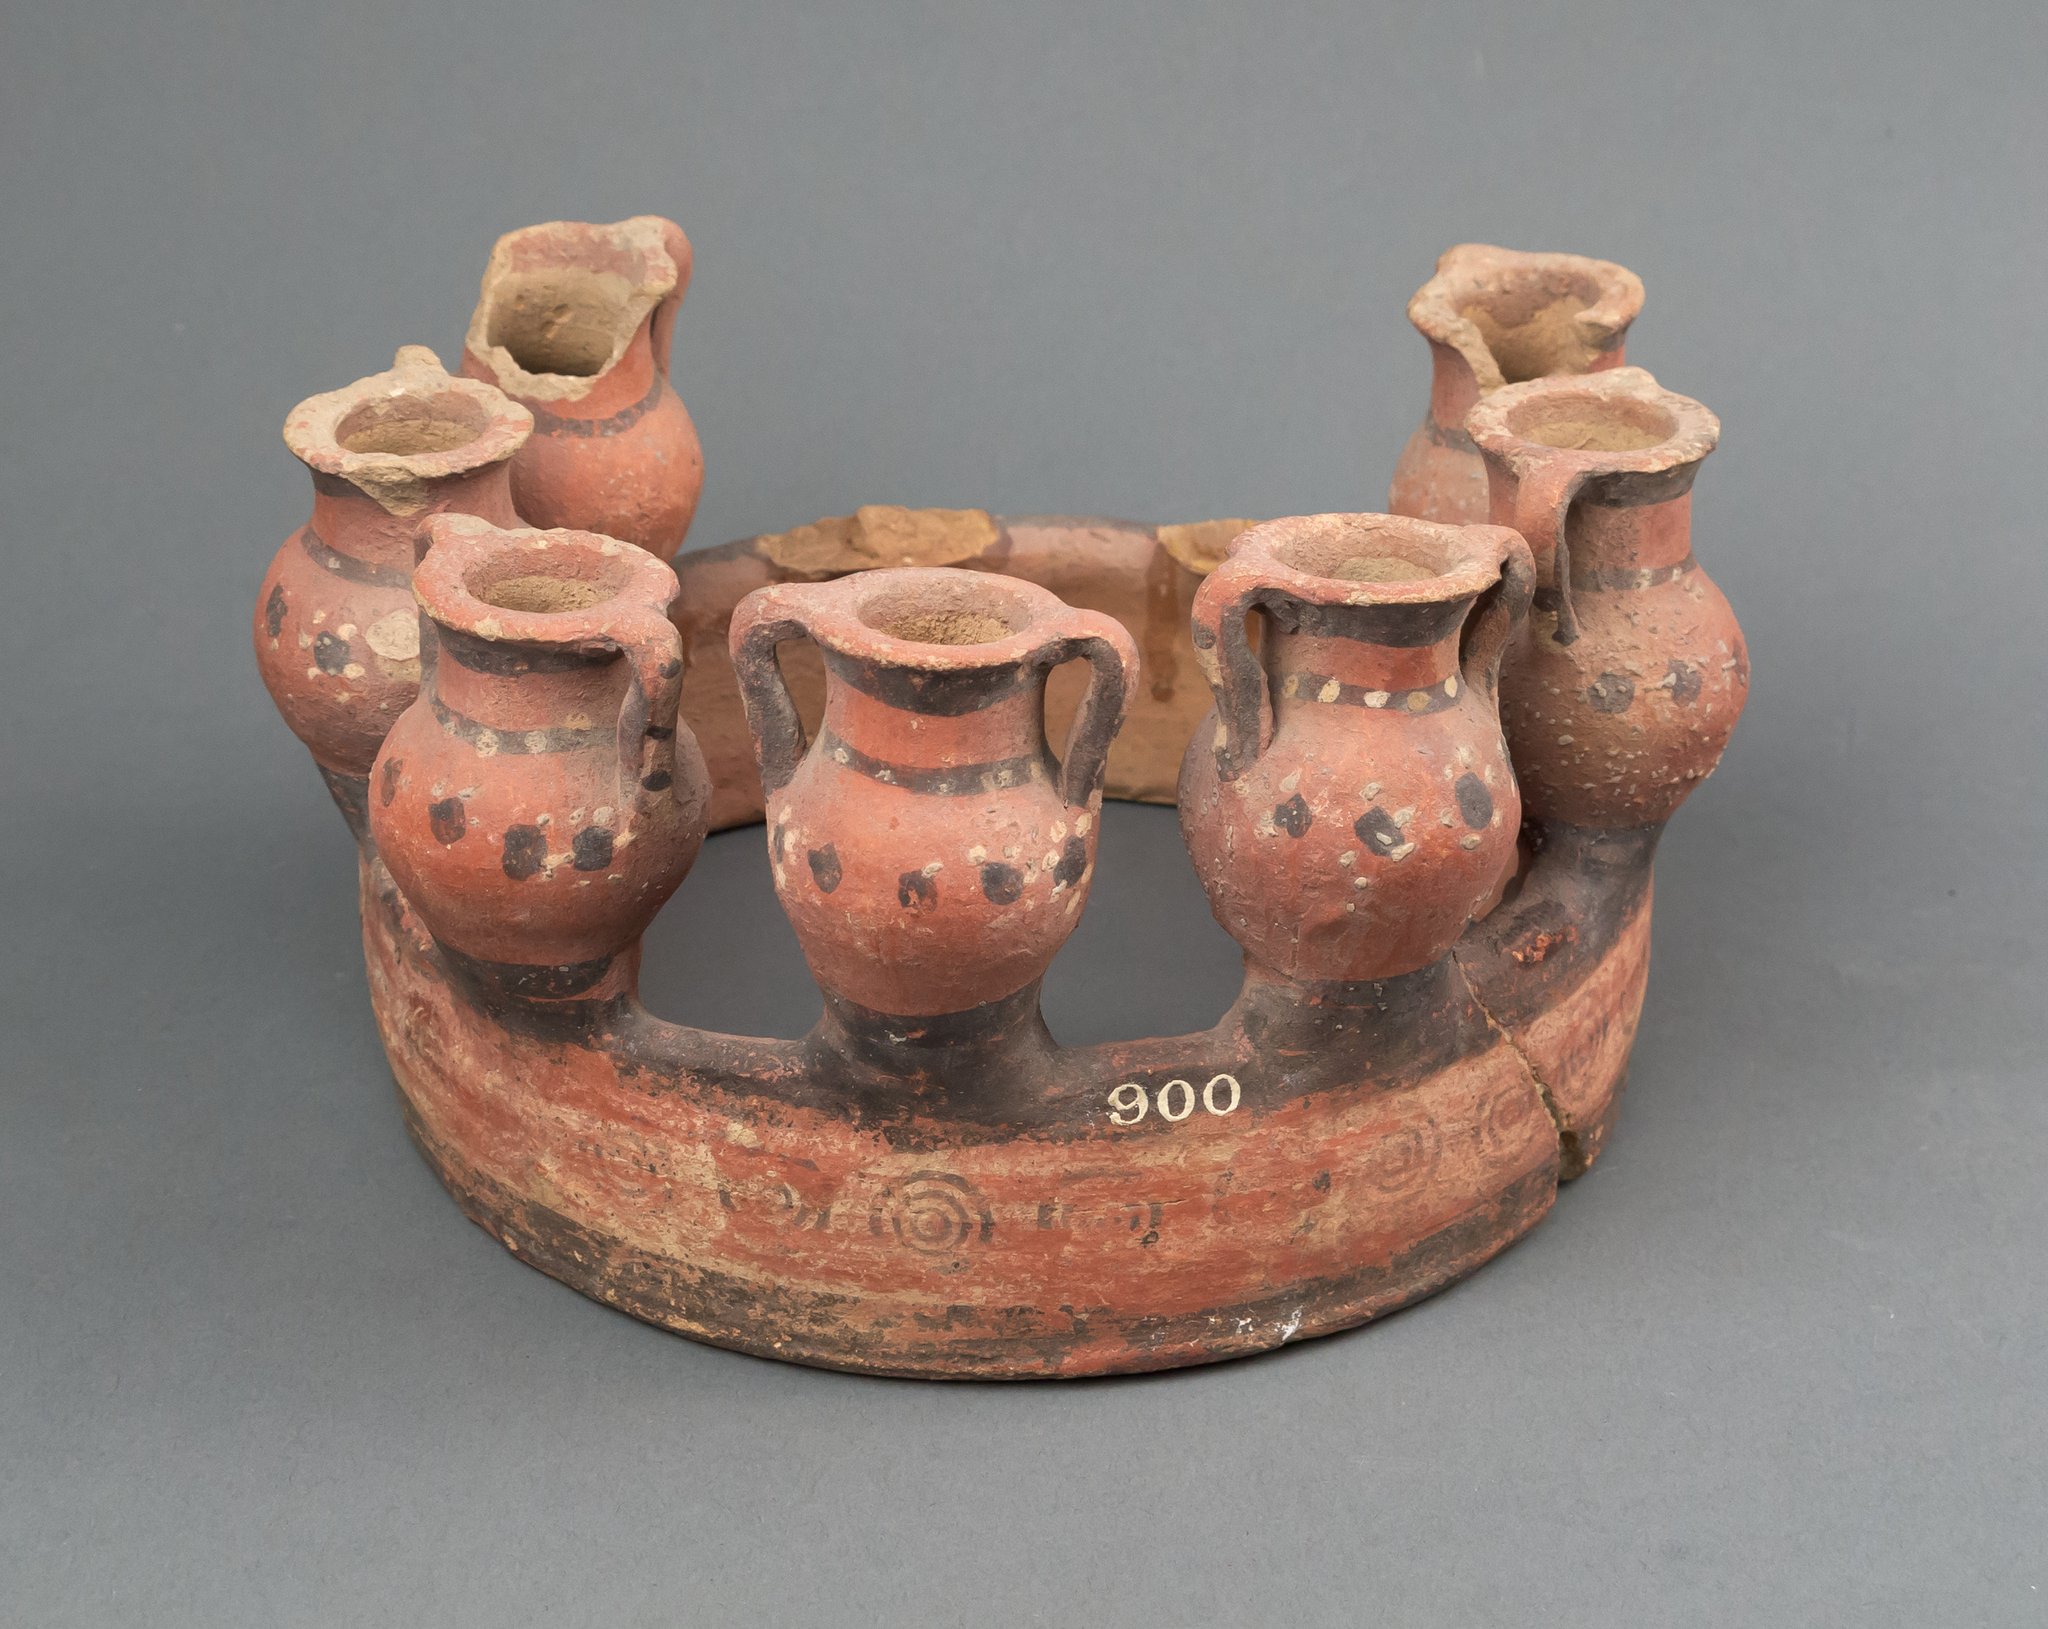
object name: kernos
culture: cypriot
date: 750-600 BCE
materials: terracotta